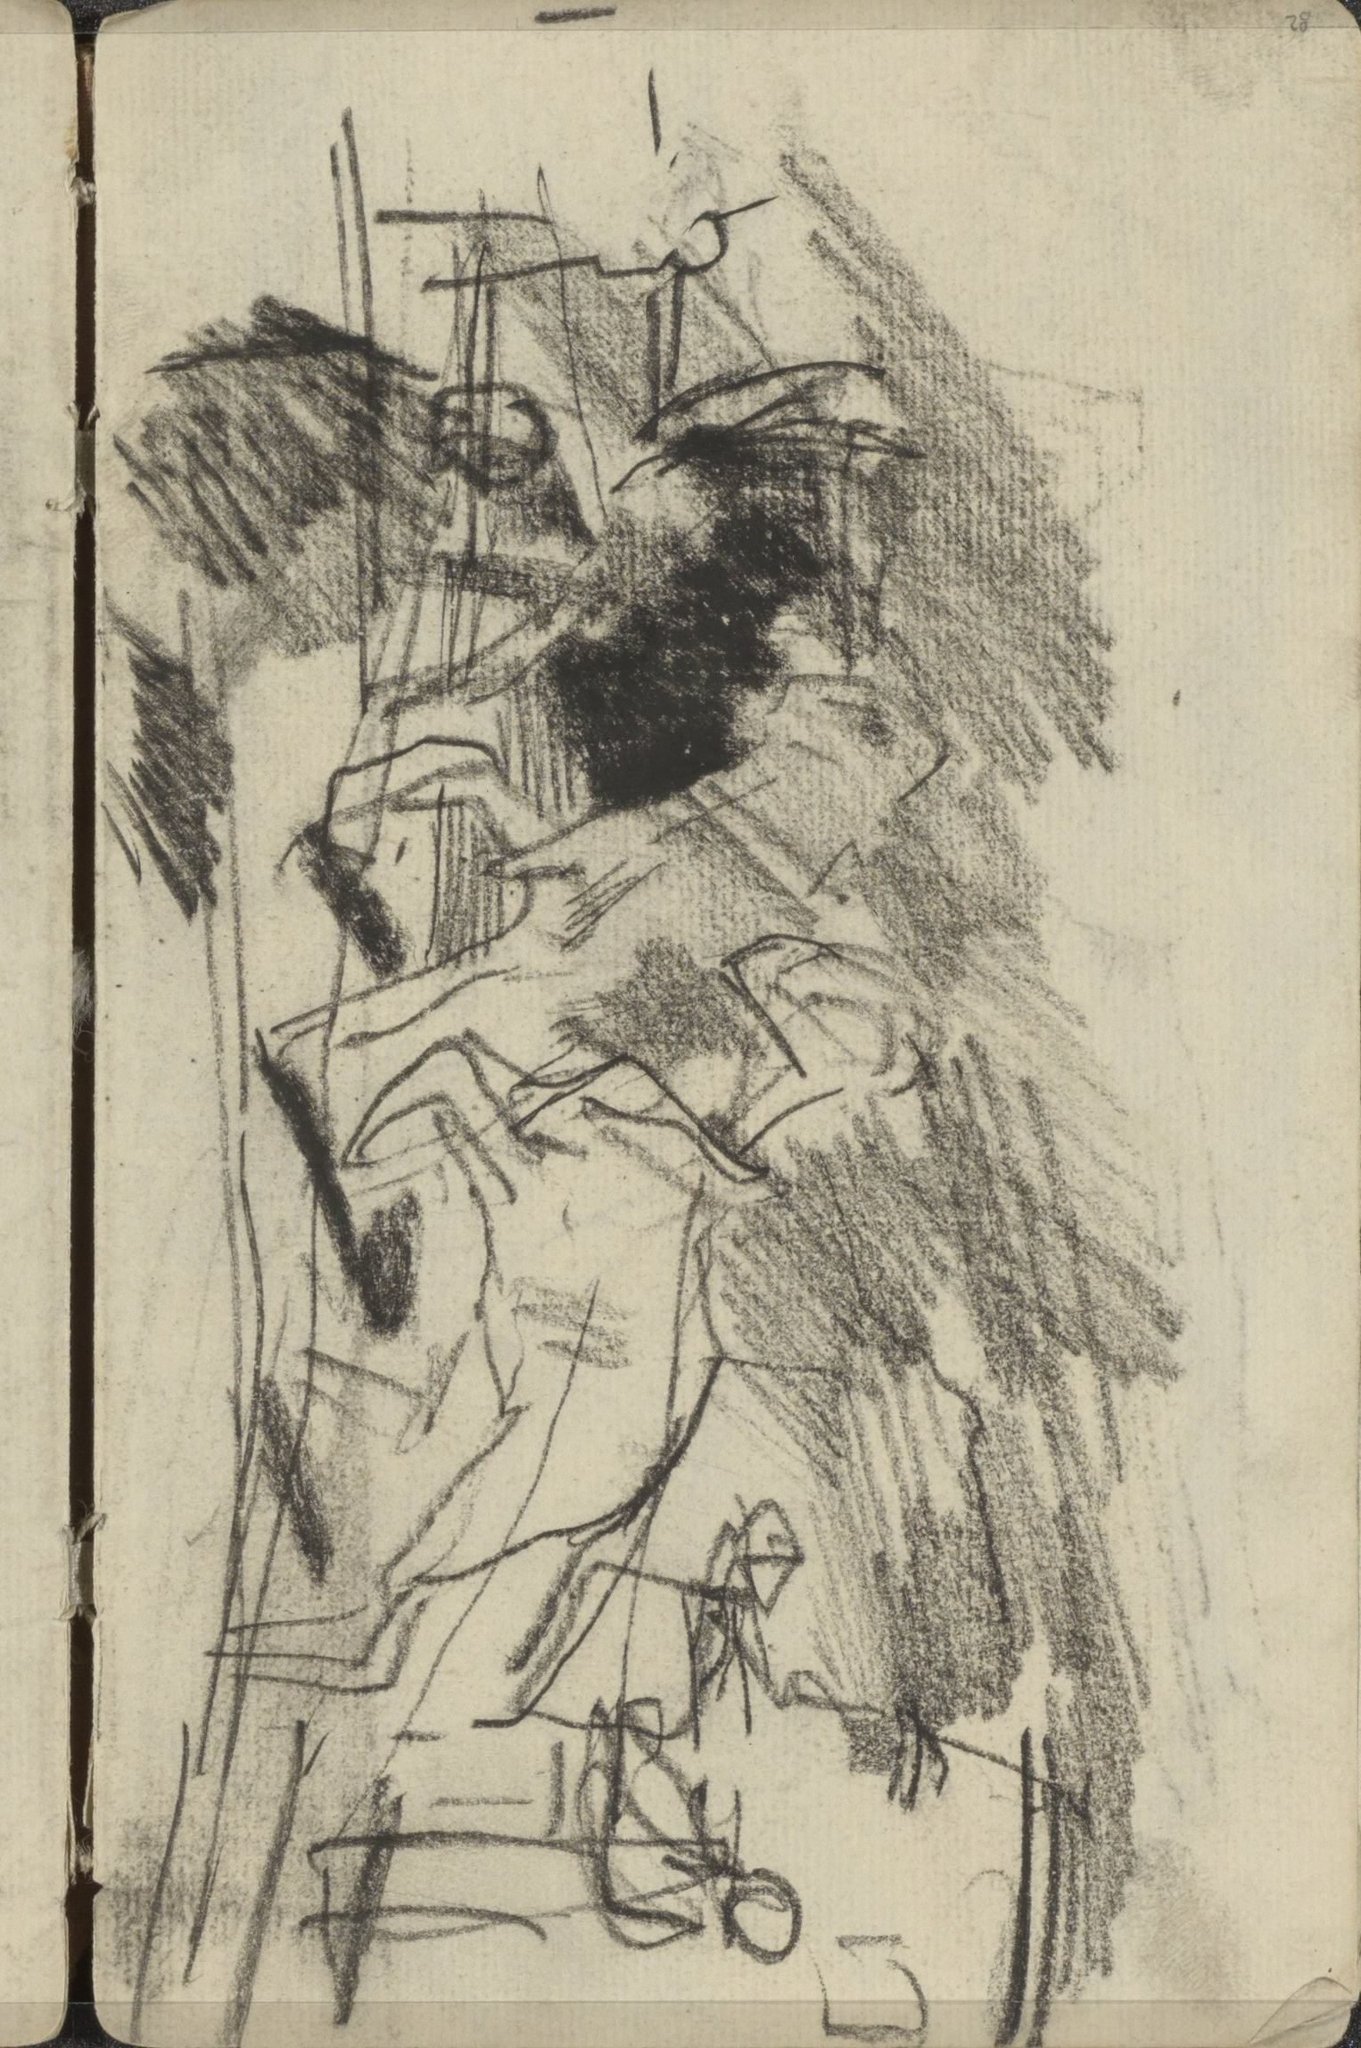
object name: sketchbook leaf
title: Figuren bij drie aangespannen paarden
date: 1883-1885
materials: chalk, paper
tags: adult man, horse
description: Pagina 28 uit een schetsboek met 16 bladen.